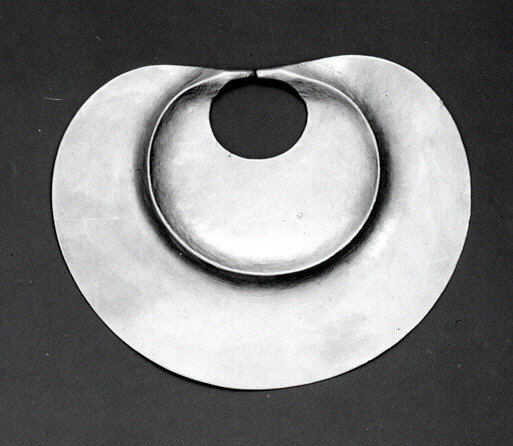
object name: nose ornament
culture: caldas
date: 801-1500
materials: gold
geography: colombia